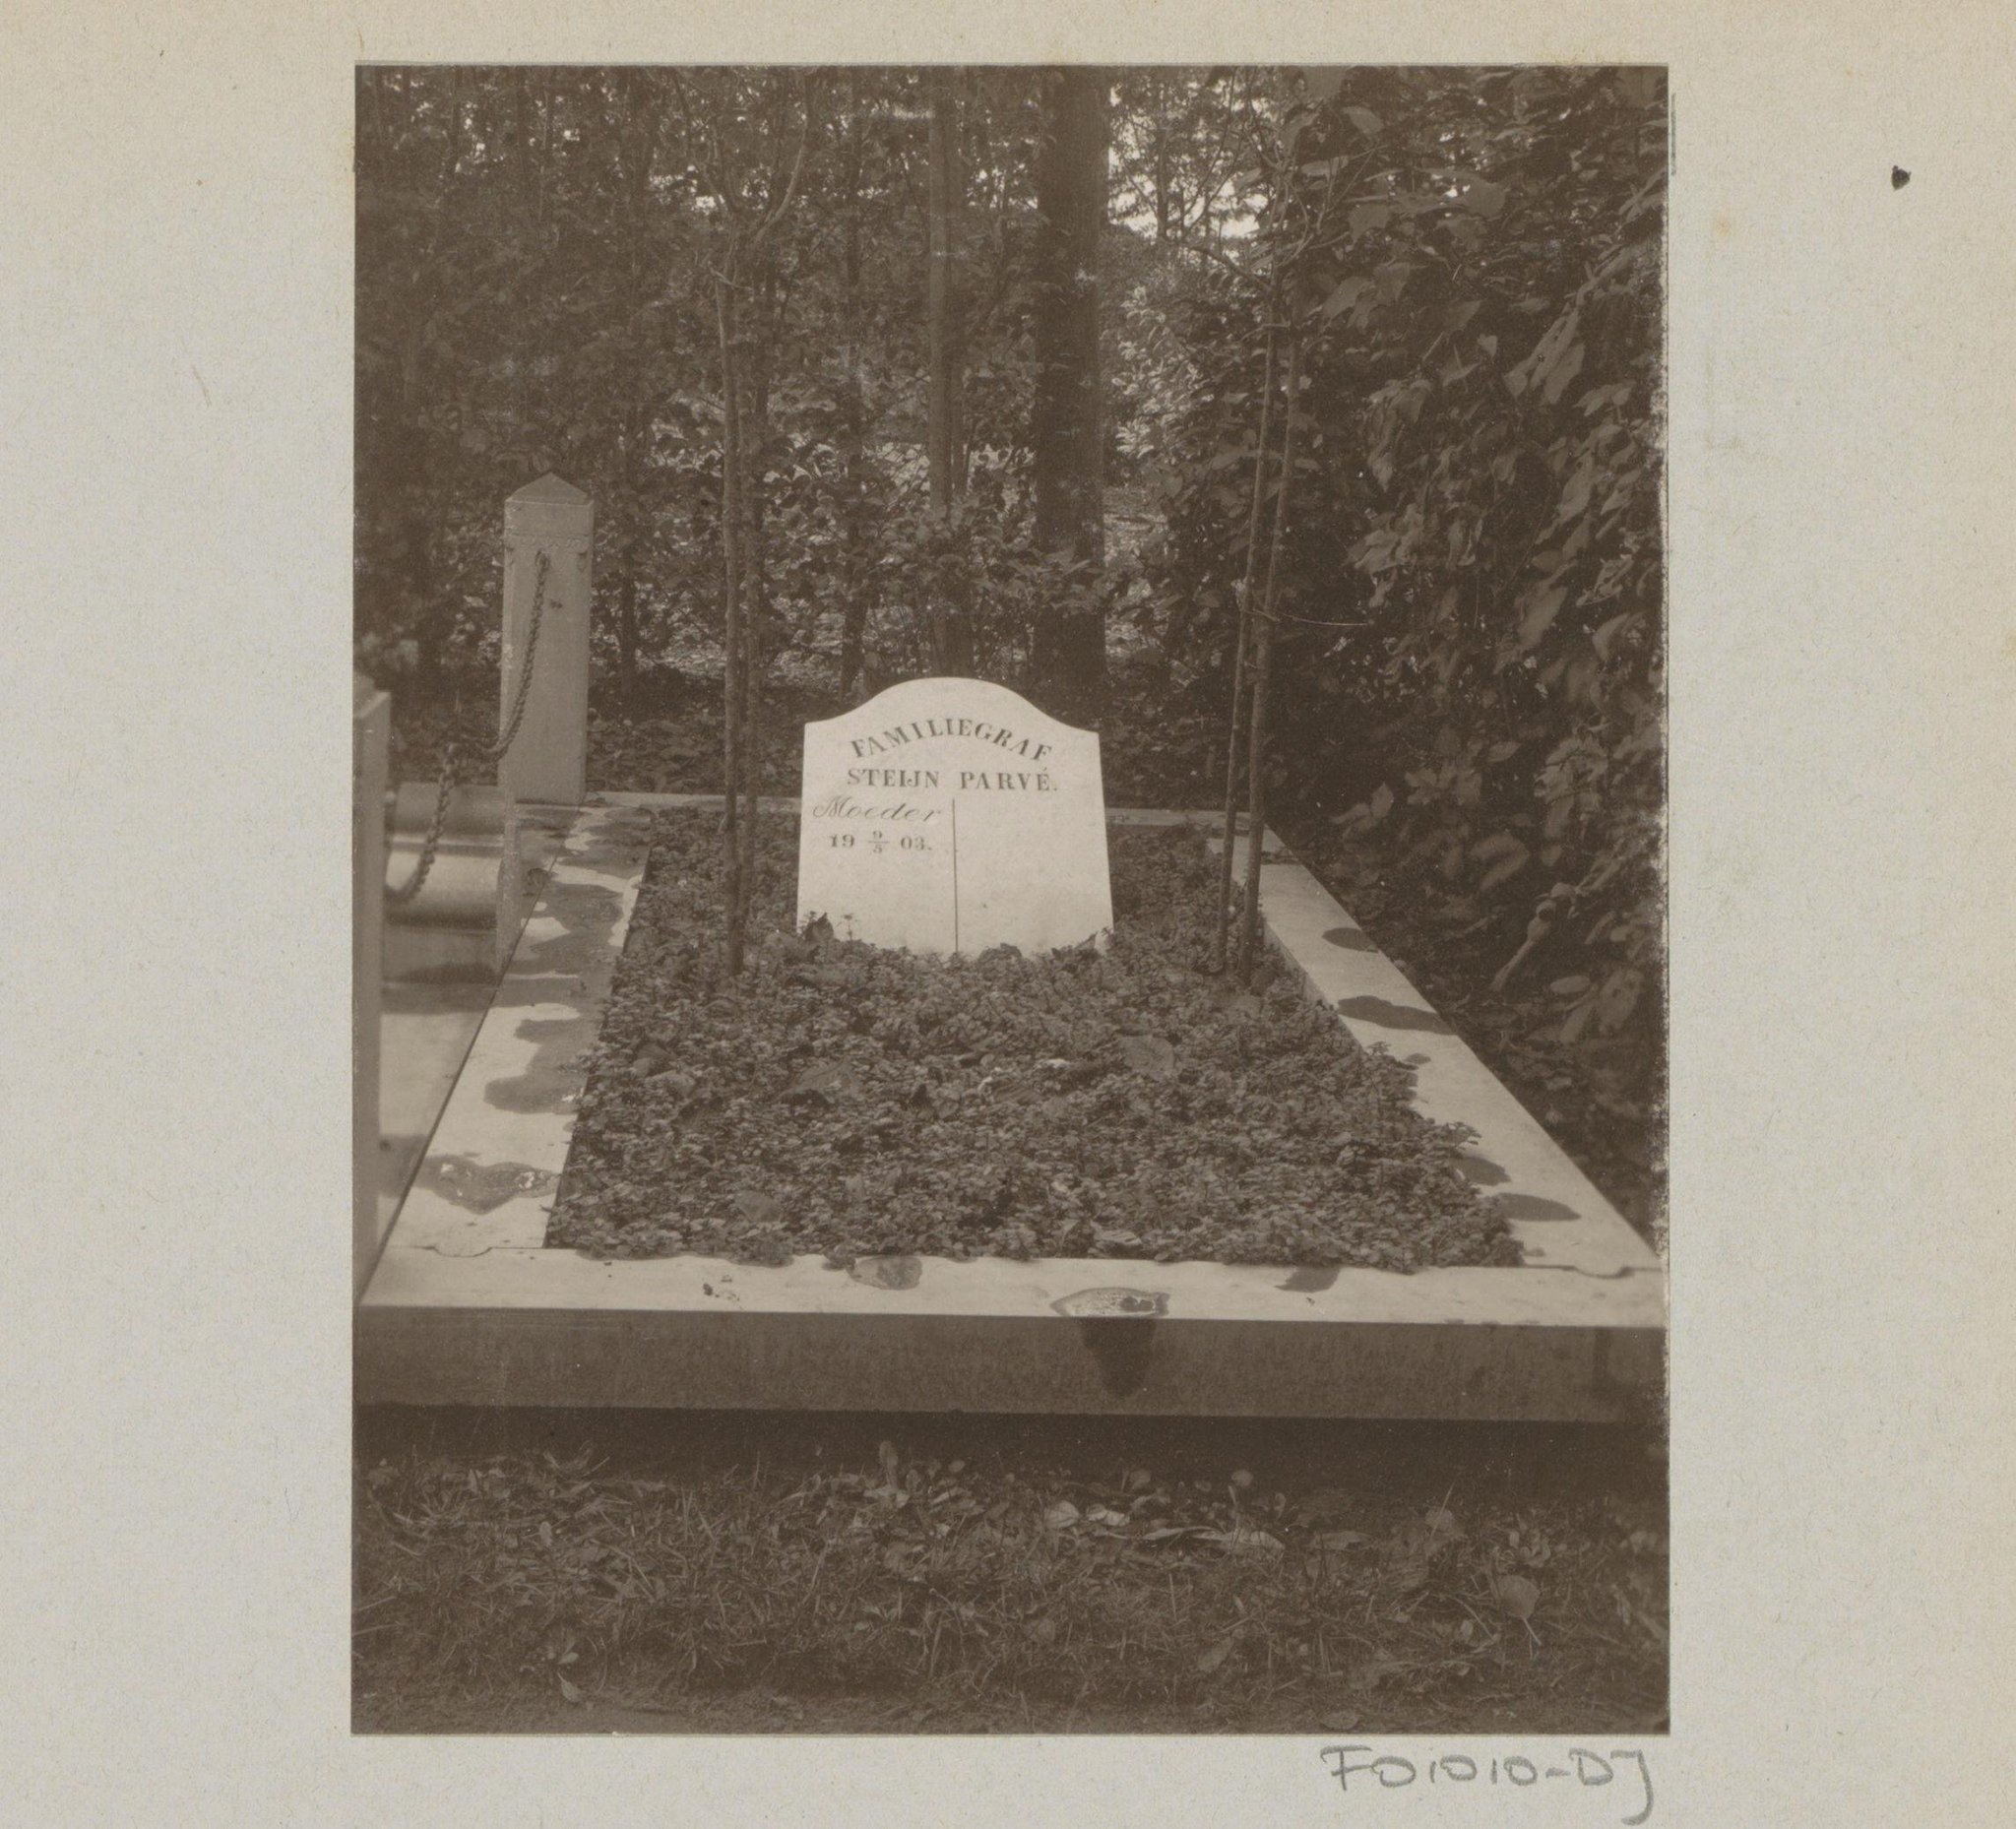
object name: photograph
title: Grafmonument van de familie Steijn Parvé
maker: Anonymous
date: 1903-1910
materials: photographic support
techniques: matte daylight collodion silver print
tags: grave, tomb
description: Onderdeel van Familiealbum met onder meer foto's van Wijnhandel Kraaij & Co. Bordeaux-Amsterdam.